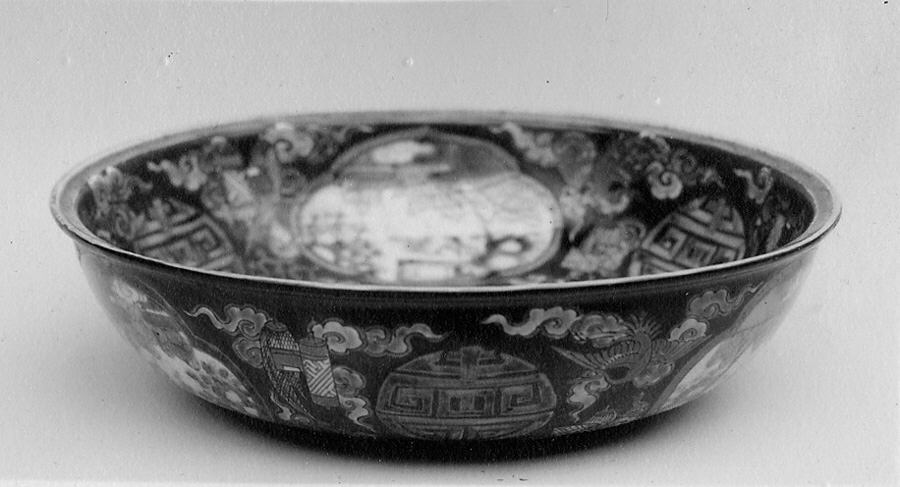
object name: bowl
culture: japanese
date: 1760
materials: enamel, porcelain